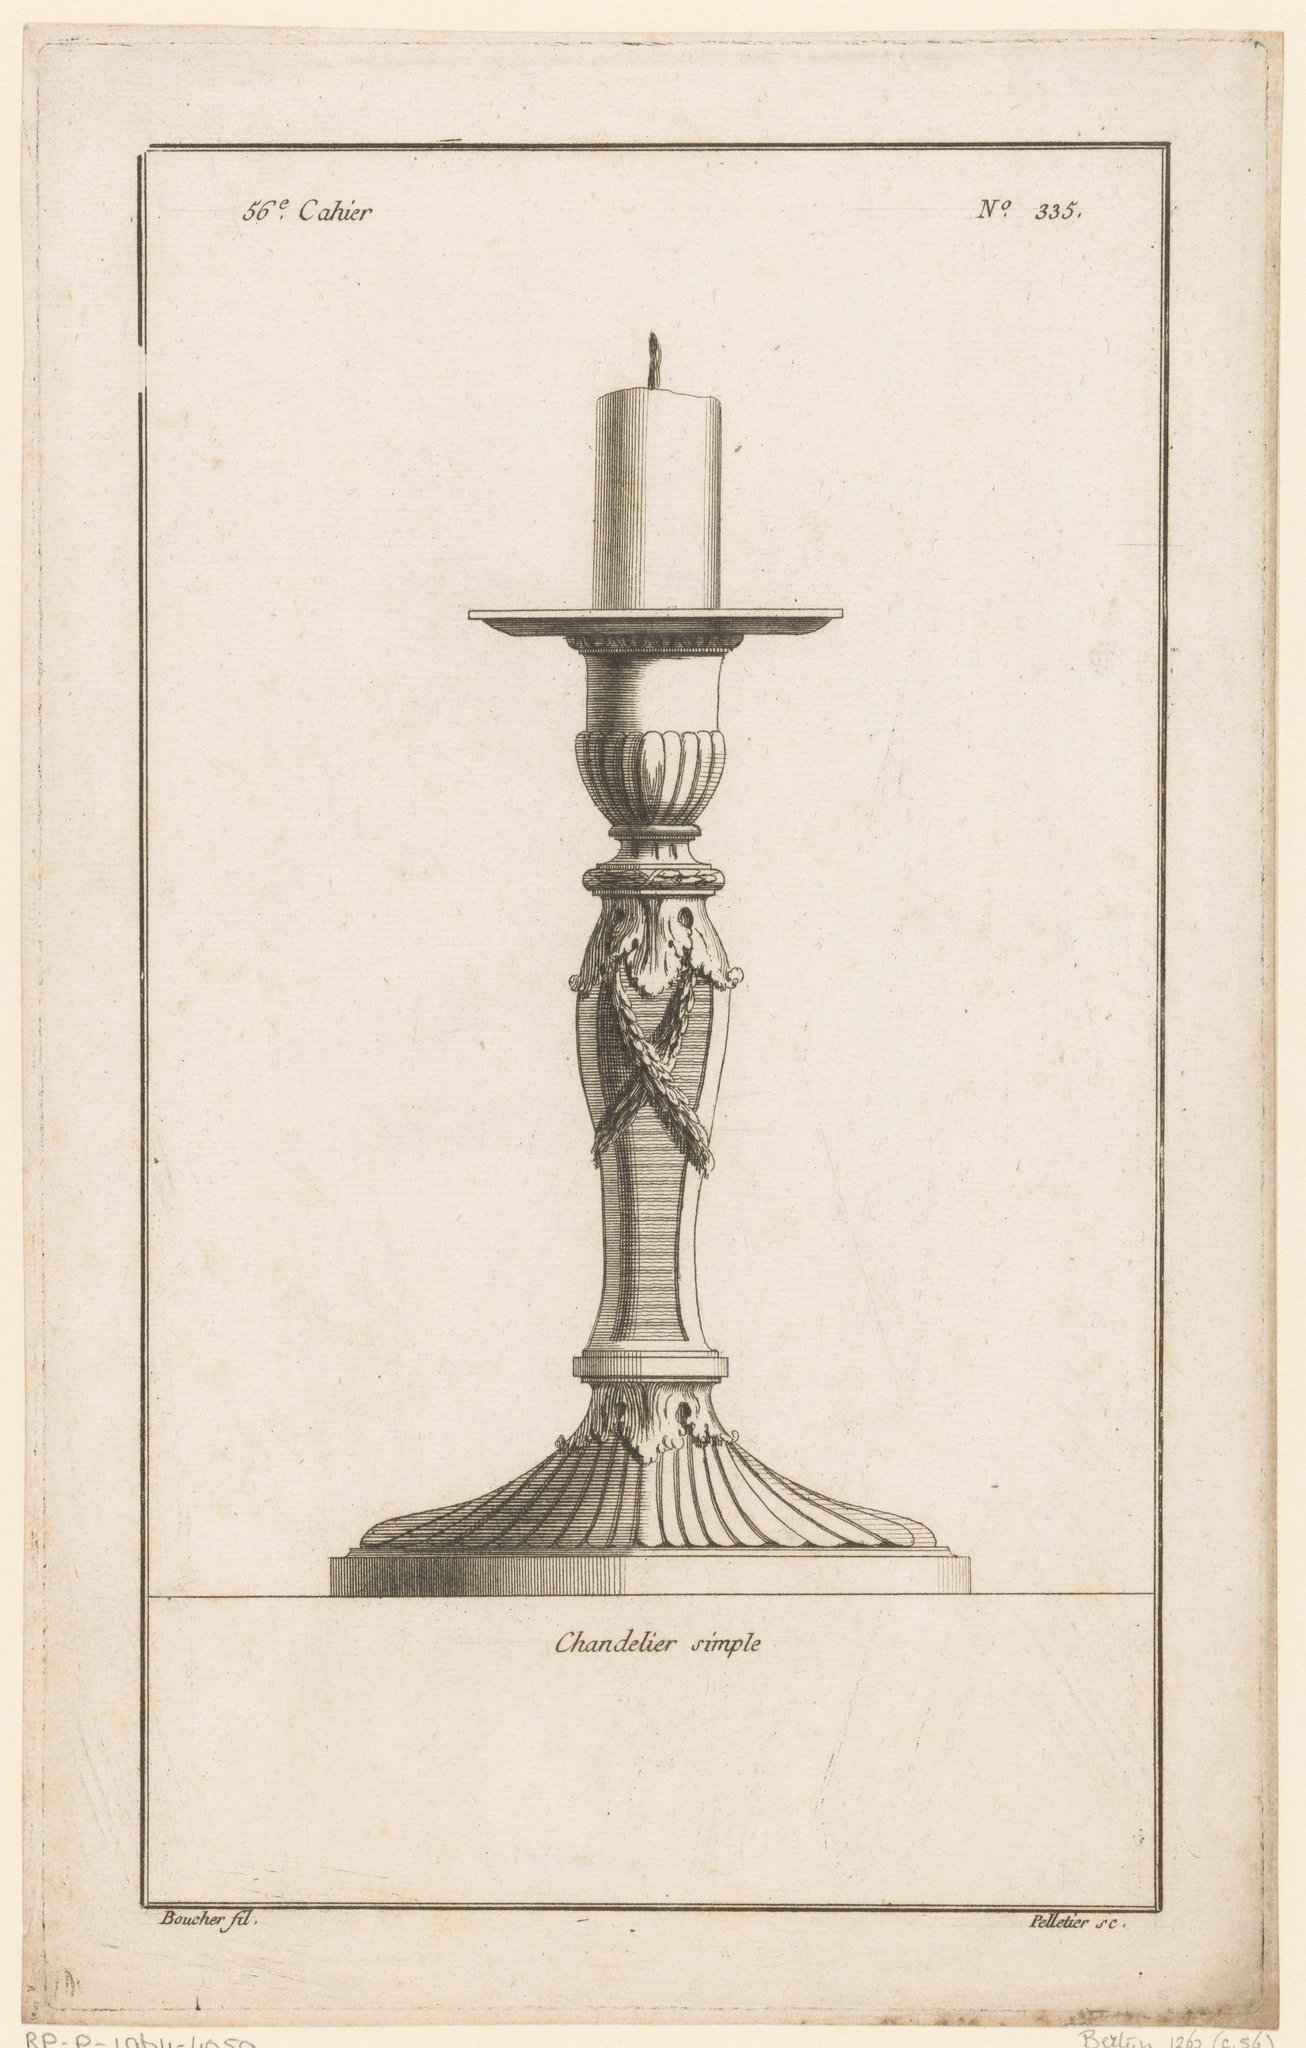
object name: print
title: 56e Cahier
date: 1772-1779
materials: paper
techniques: engraving, etching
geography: paris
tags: chandelier, candelabrum, ornament ~ festoon, garland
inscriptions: collector's mark: Lugt 2760, collector's mark: Lugt 2228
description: Een geornamenteerde kandelaar met guirlandes. Prentnummer 335.